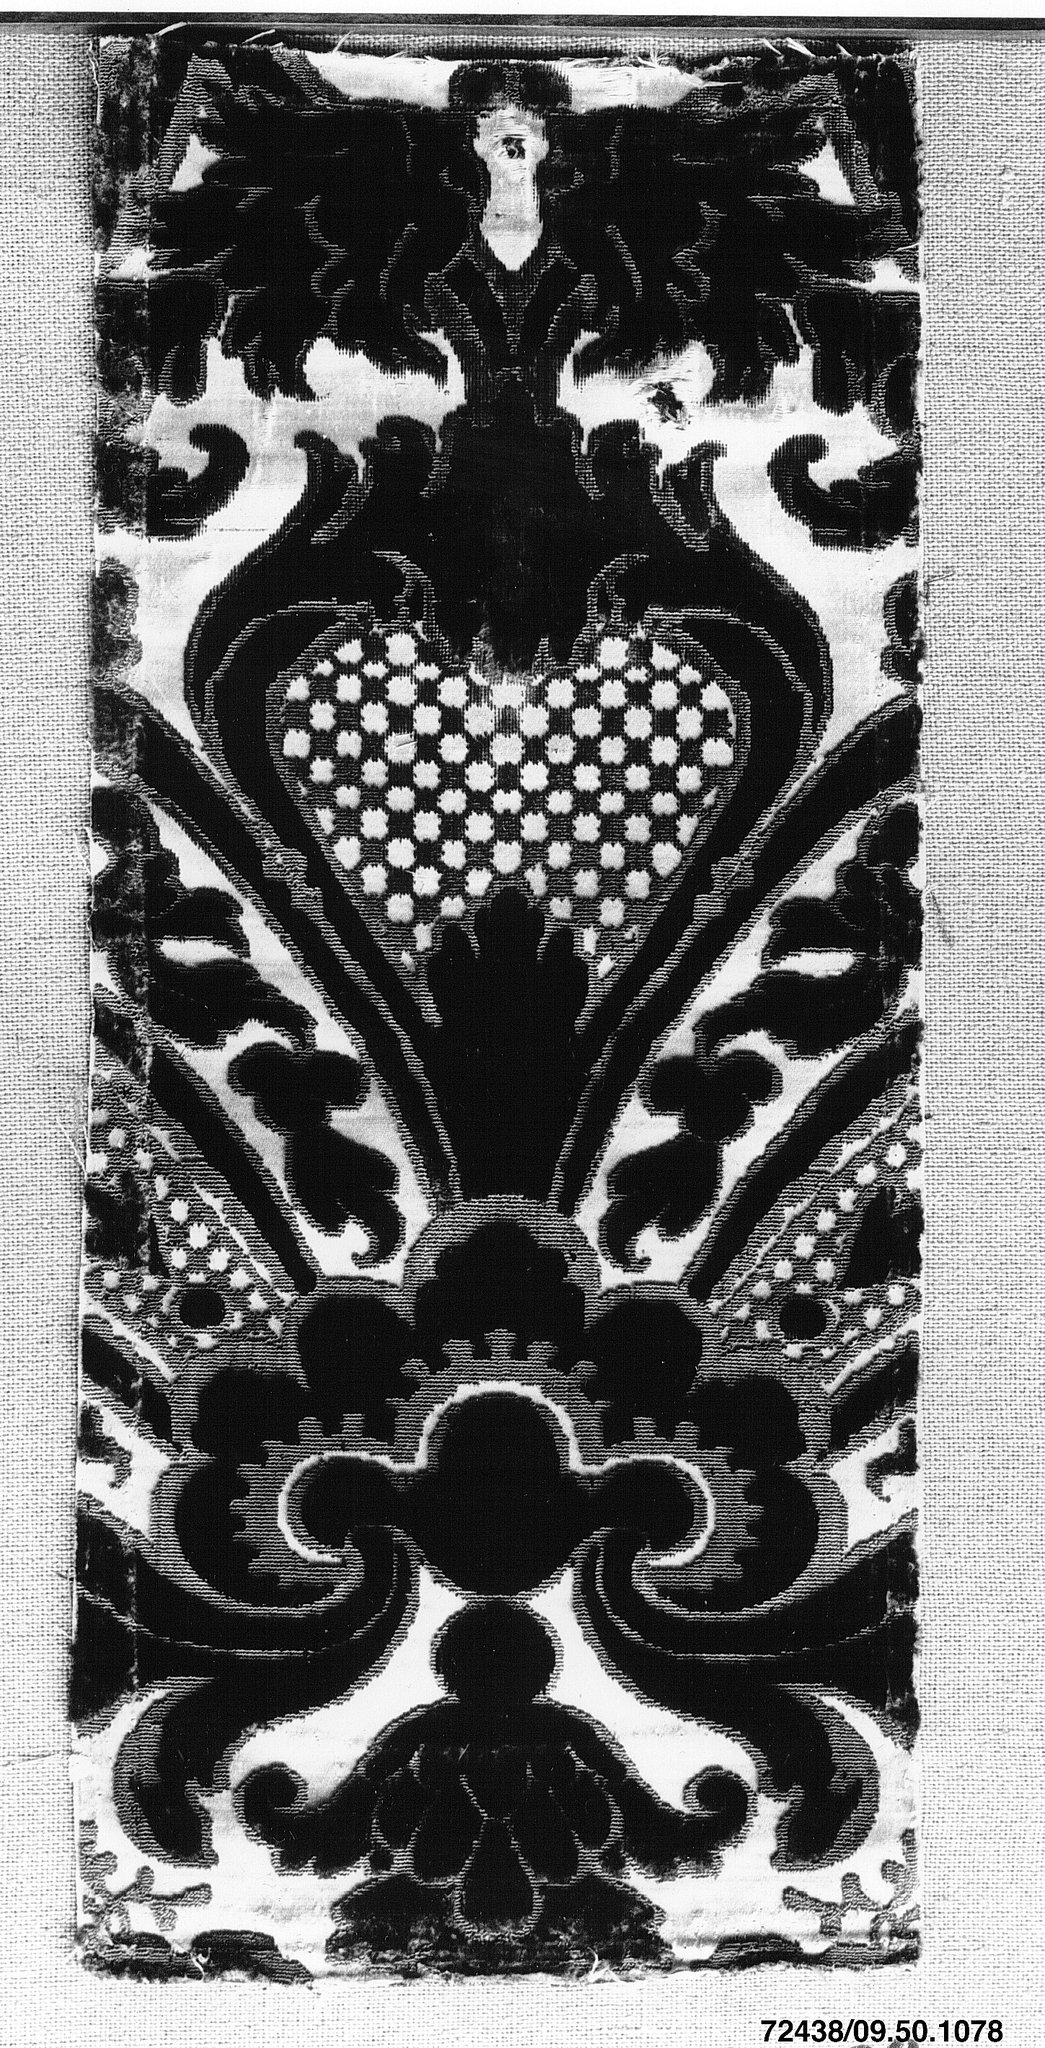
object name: piece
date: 1601-1700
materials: silk